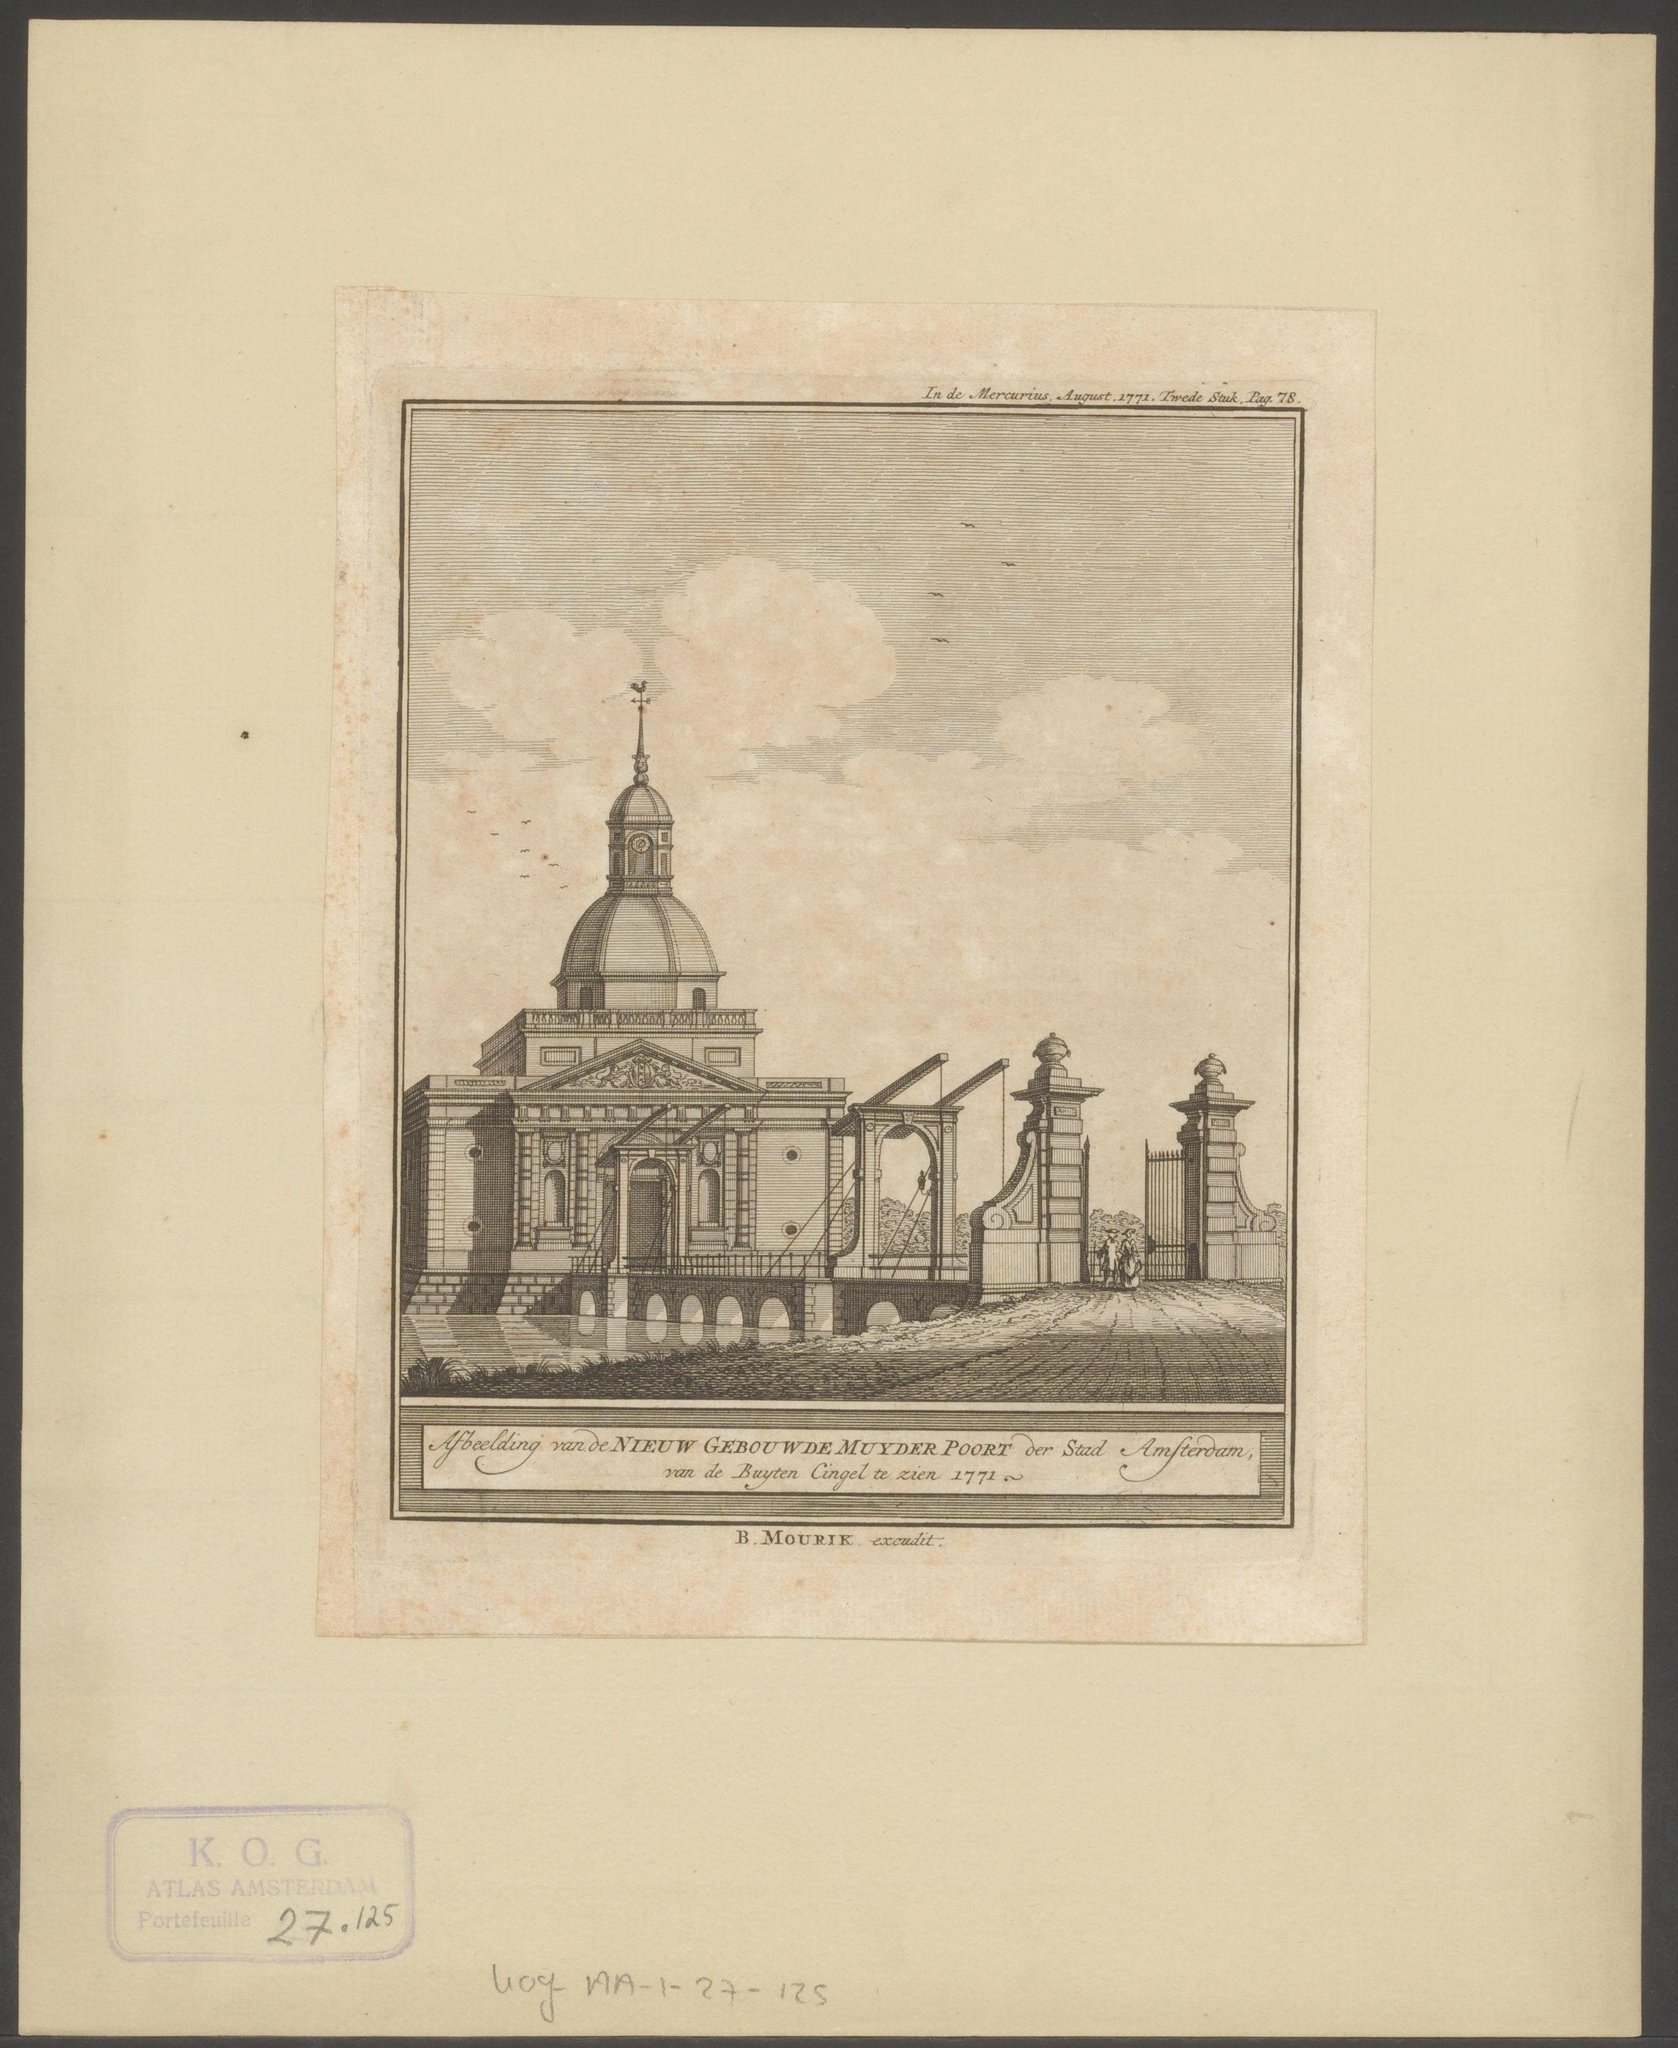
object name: print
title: Afbeelding van de Nieuw Gebouwde Muyder Poort der Stad Amsterdam, van de Buyten Cingel te zien 1771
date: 1708-1771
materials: paper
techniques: engraving, etching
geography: amsterdam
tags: city-gate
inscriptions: collector's mark: Lugt 1641b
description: Gezicht op de in 1770 gebouwde Tweede Muiderpoort te Amsterdam. Rechtsboven genummerd: In de Mercurius, August. 1771. Twede Stuk. Pag 78. Onderwerpsrubriek binnen de Atlas Amsterdam: Poorten, verzamelbladen, J. Tweede Muiderpoort.